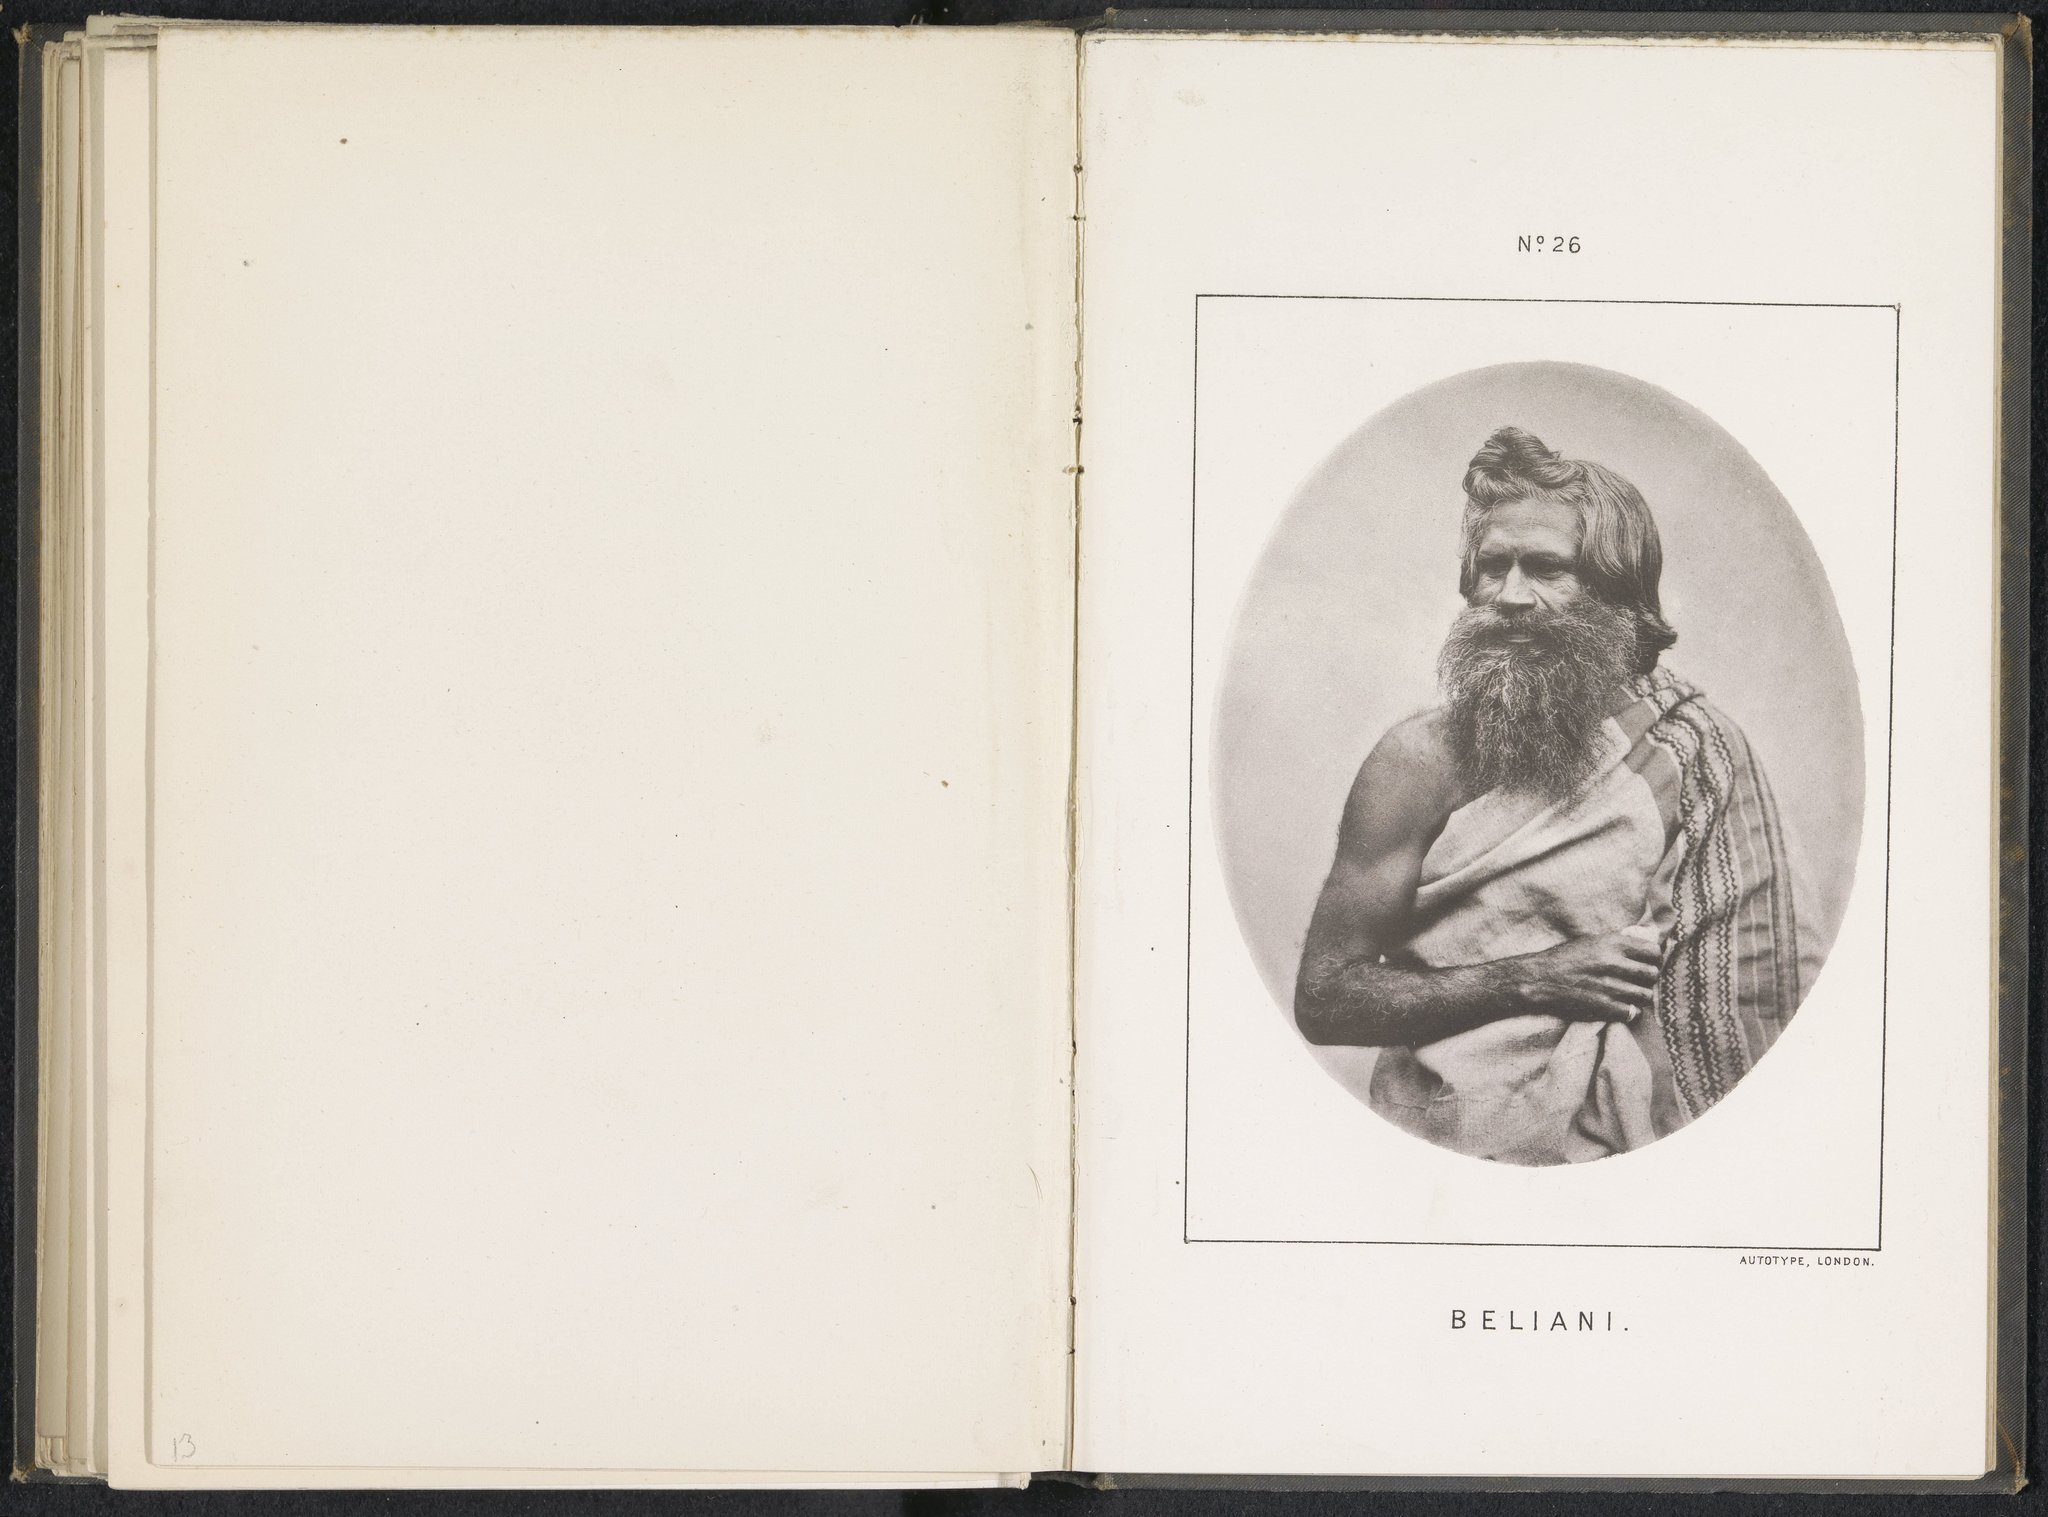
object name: photomechanical print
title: Beliani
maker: Anonymous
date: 1863-1873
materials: paper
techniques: photograph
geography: london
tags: adult man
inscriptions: number: ‘No. 26’